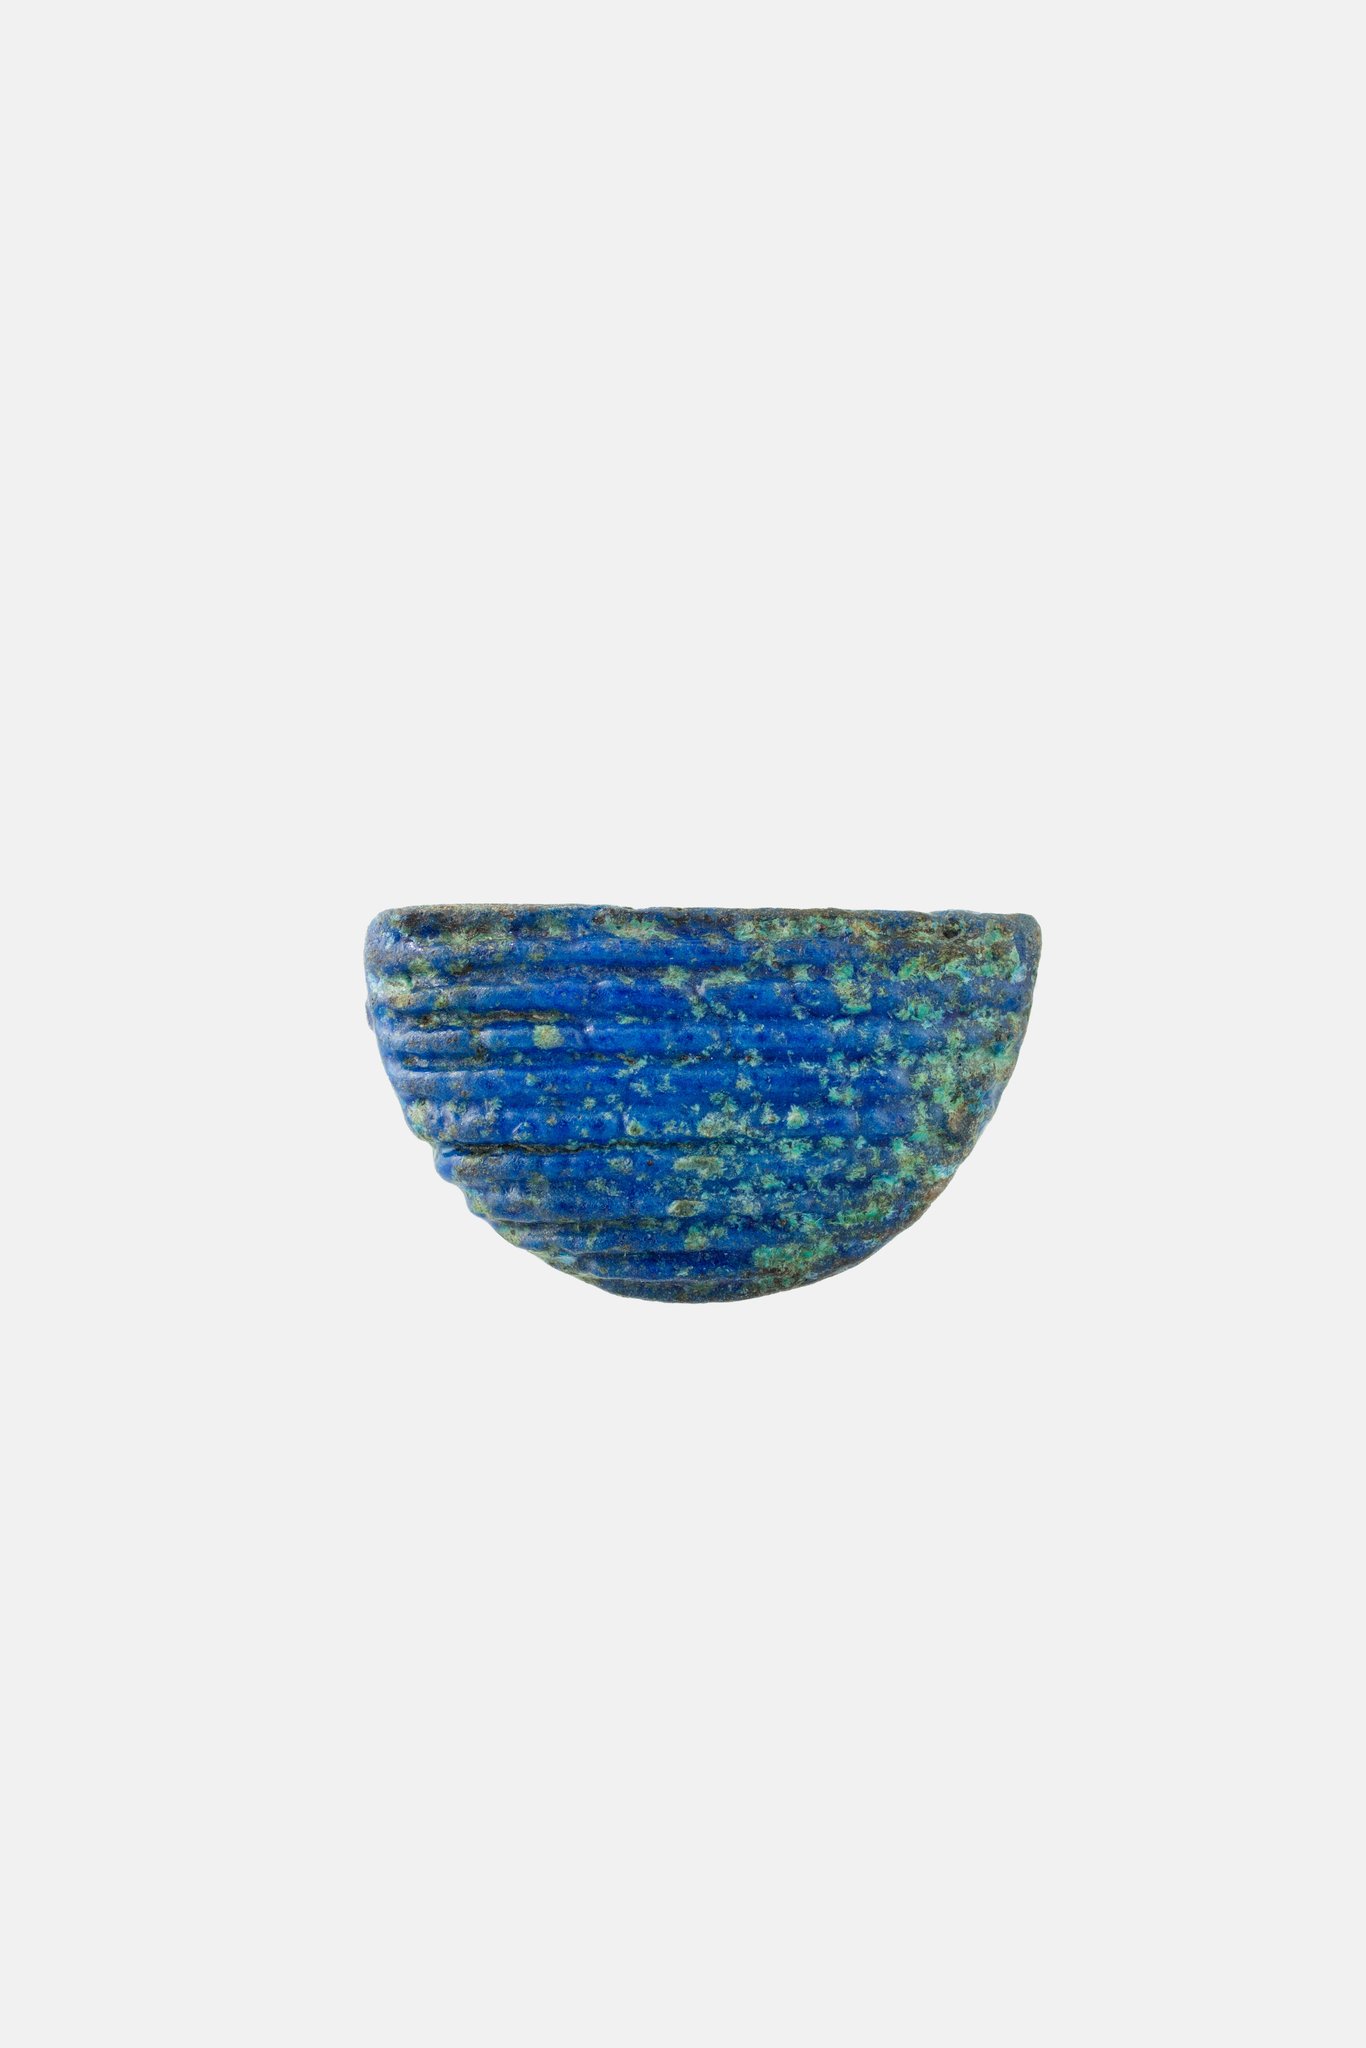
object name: inlay, hieroglyph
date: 664-610 BCE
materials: faience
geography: egypt